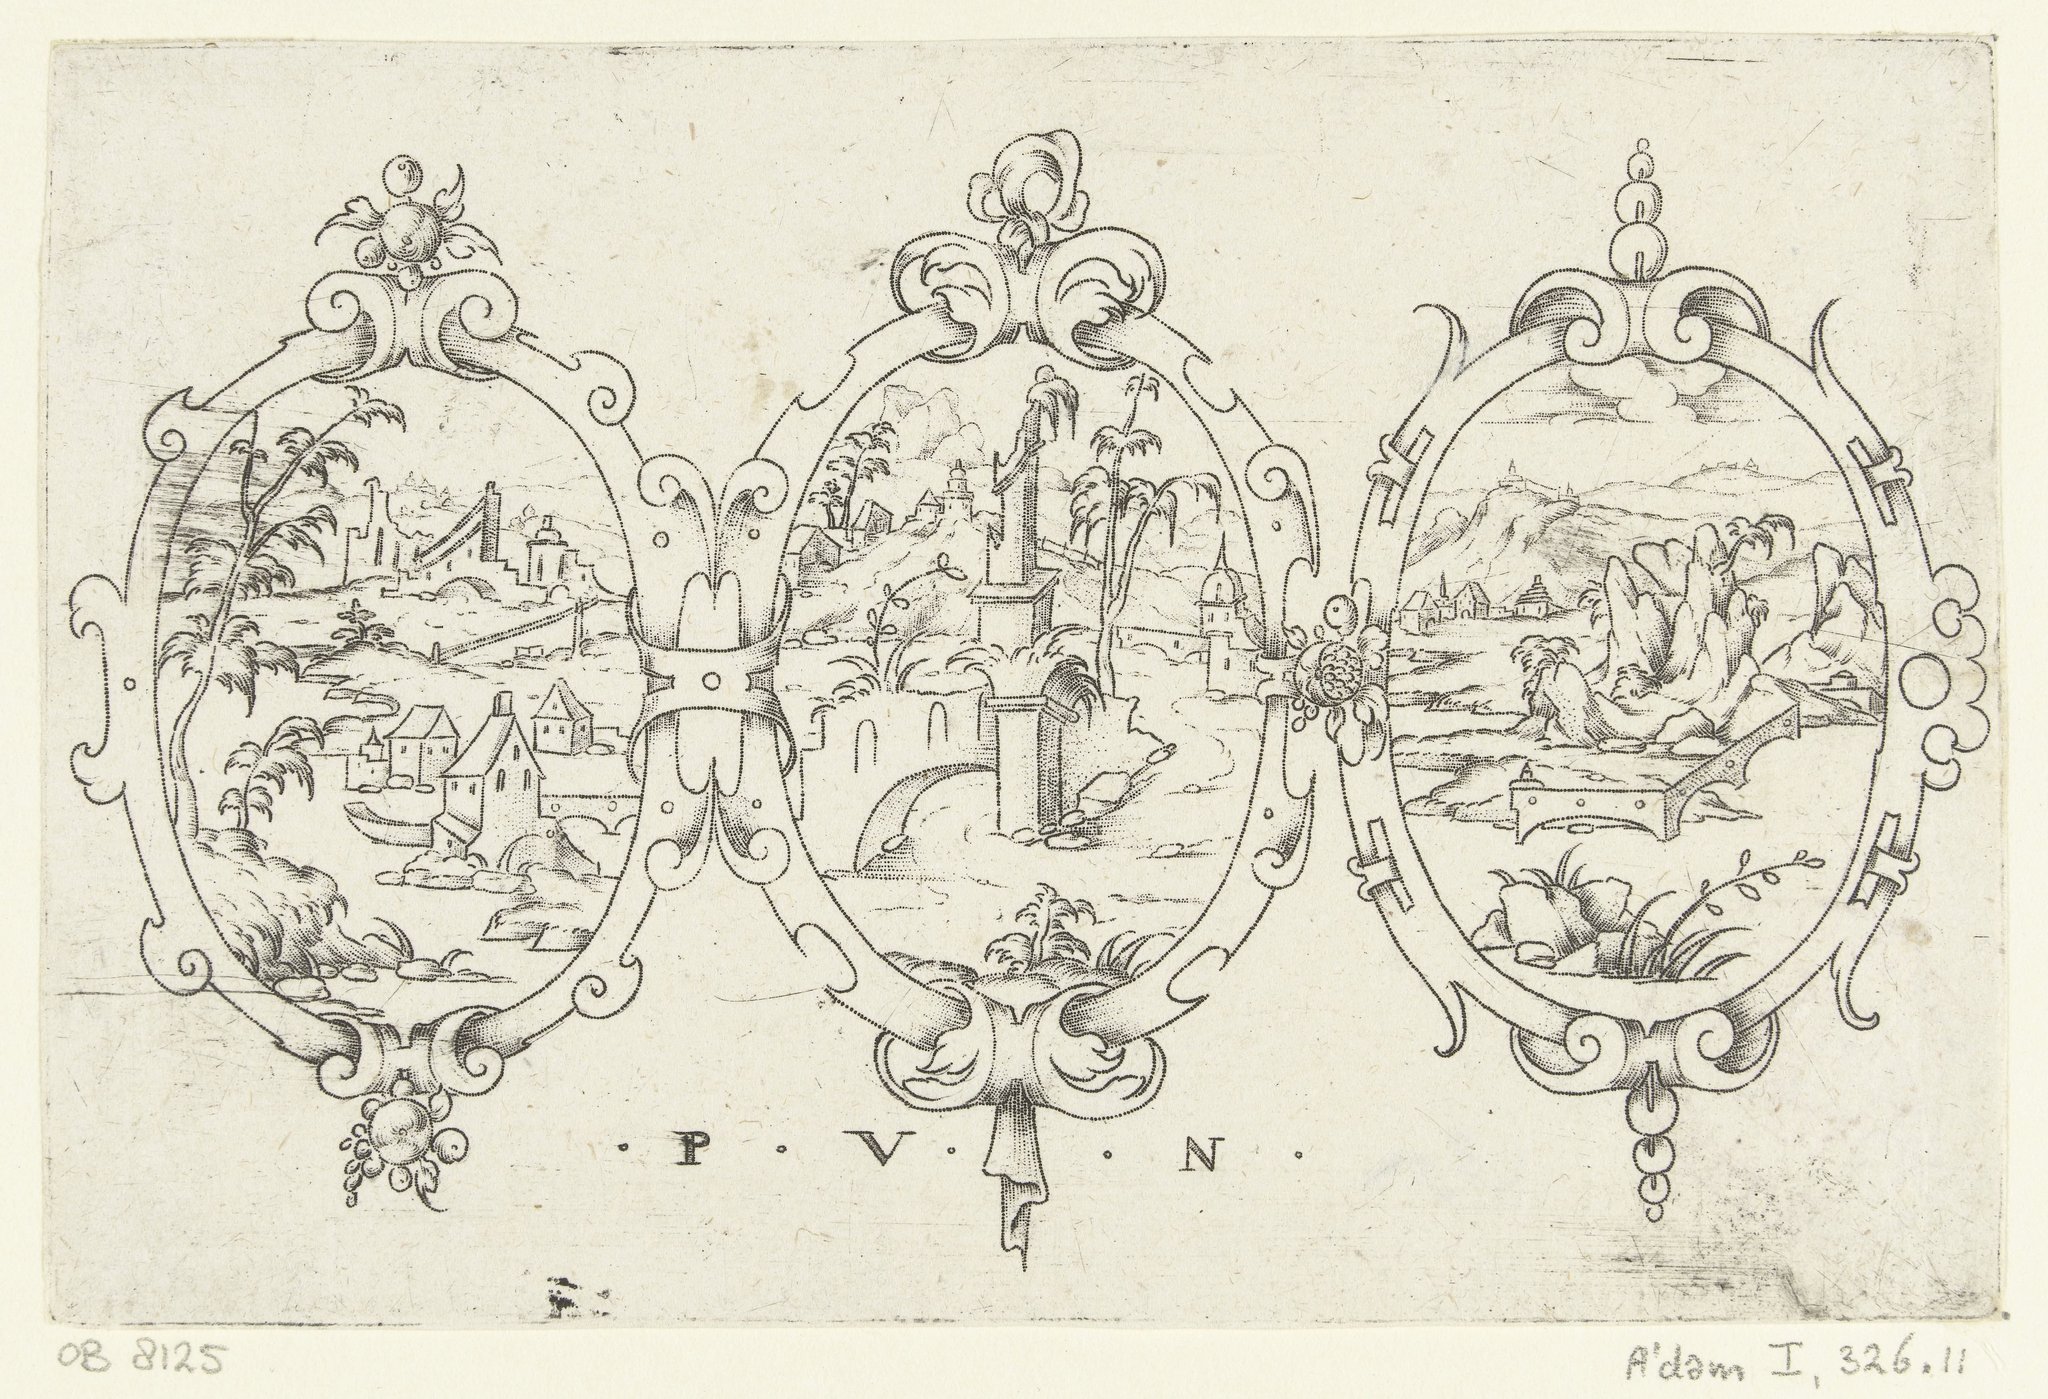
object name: print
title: Drie ovalen met landschappen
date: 1600-1699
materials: paper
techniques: engraving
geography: germany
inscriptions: collector's mark: Lugt 240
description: In het middelste landschap bevindt zich een ruïne. Uit serie van 12 bladen.